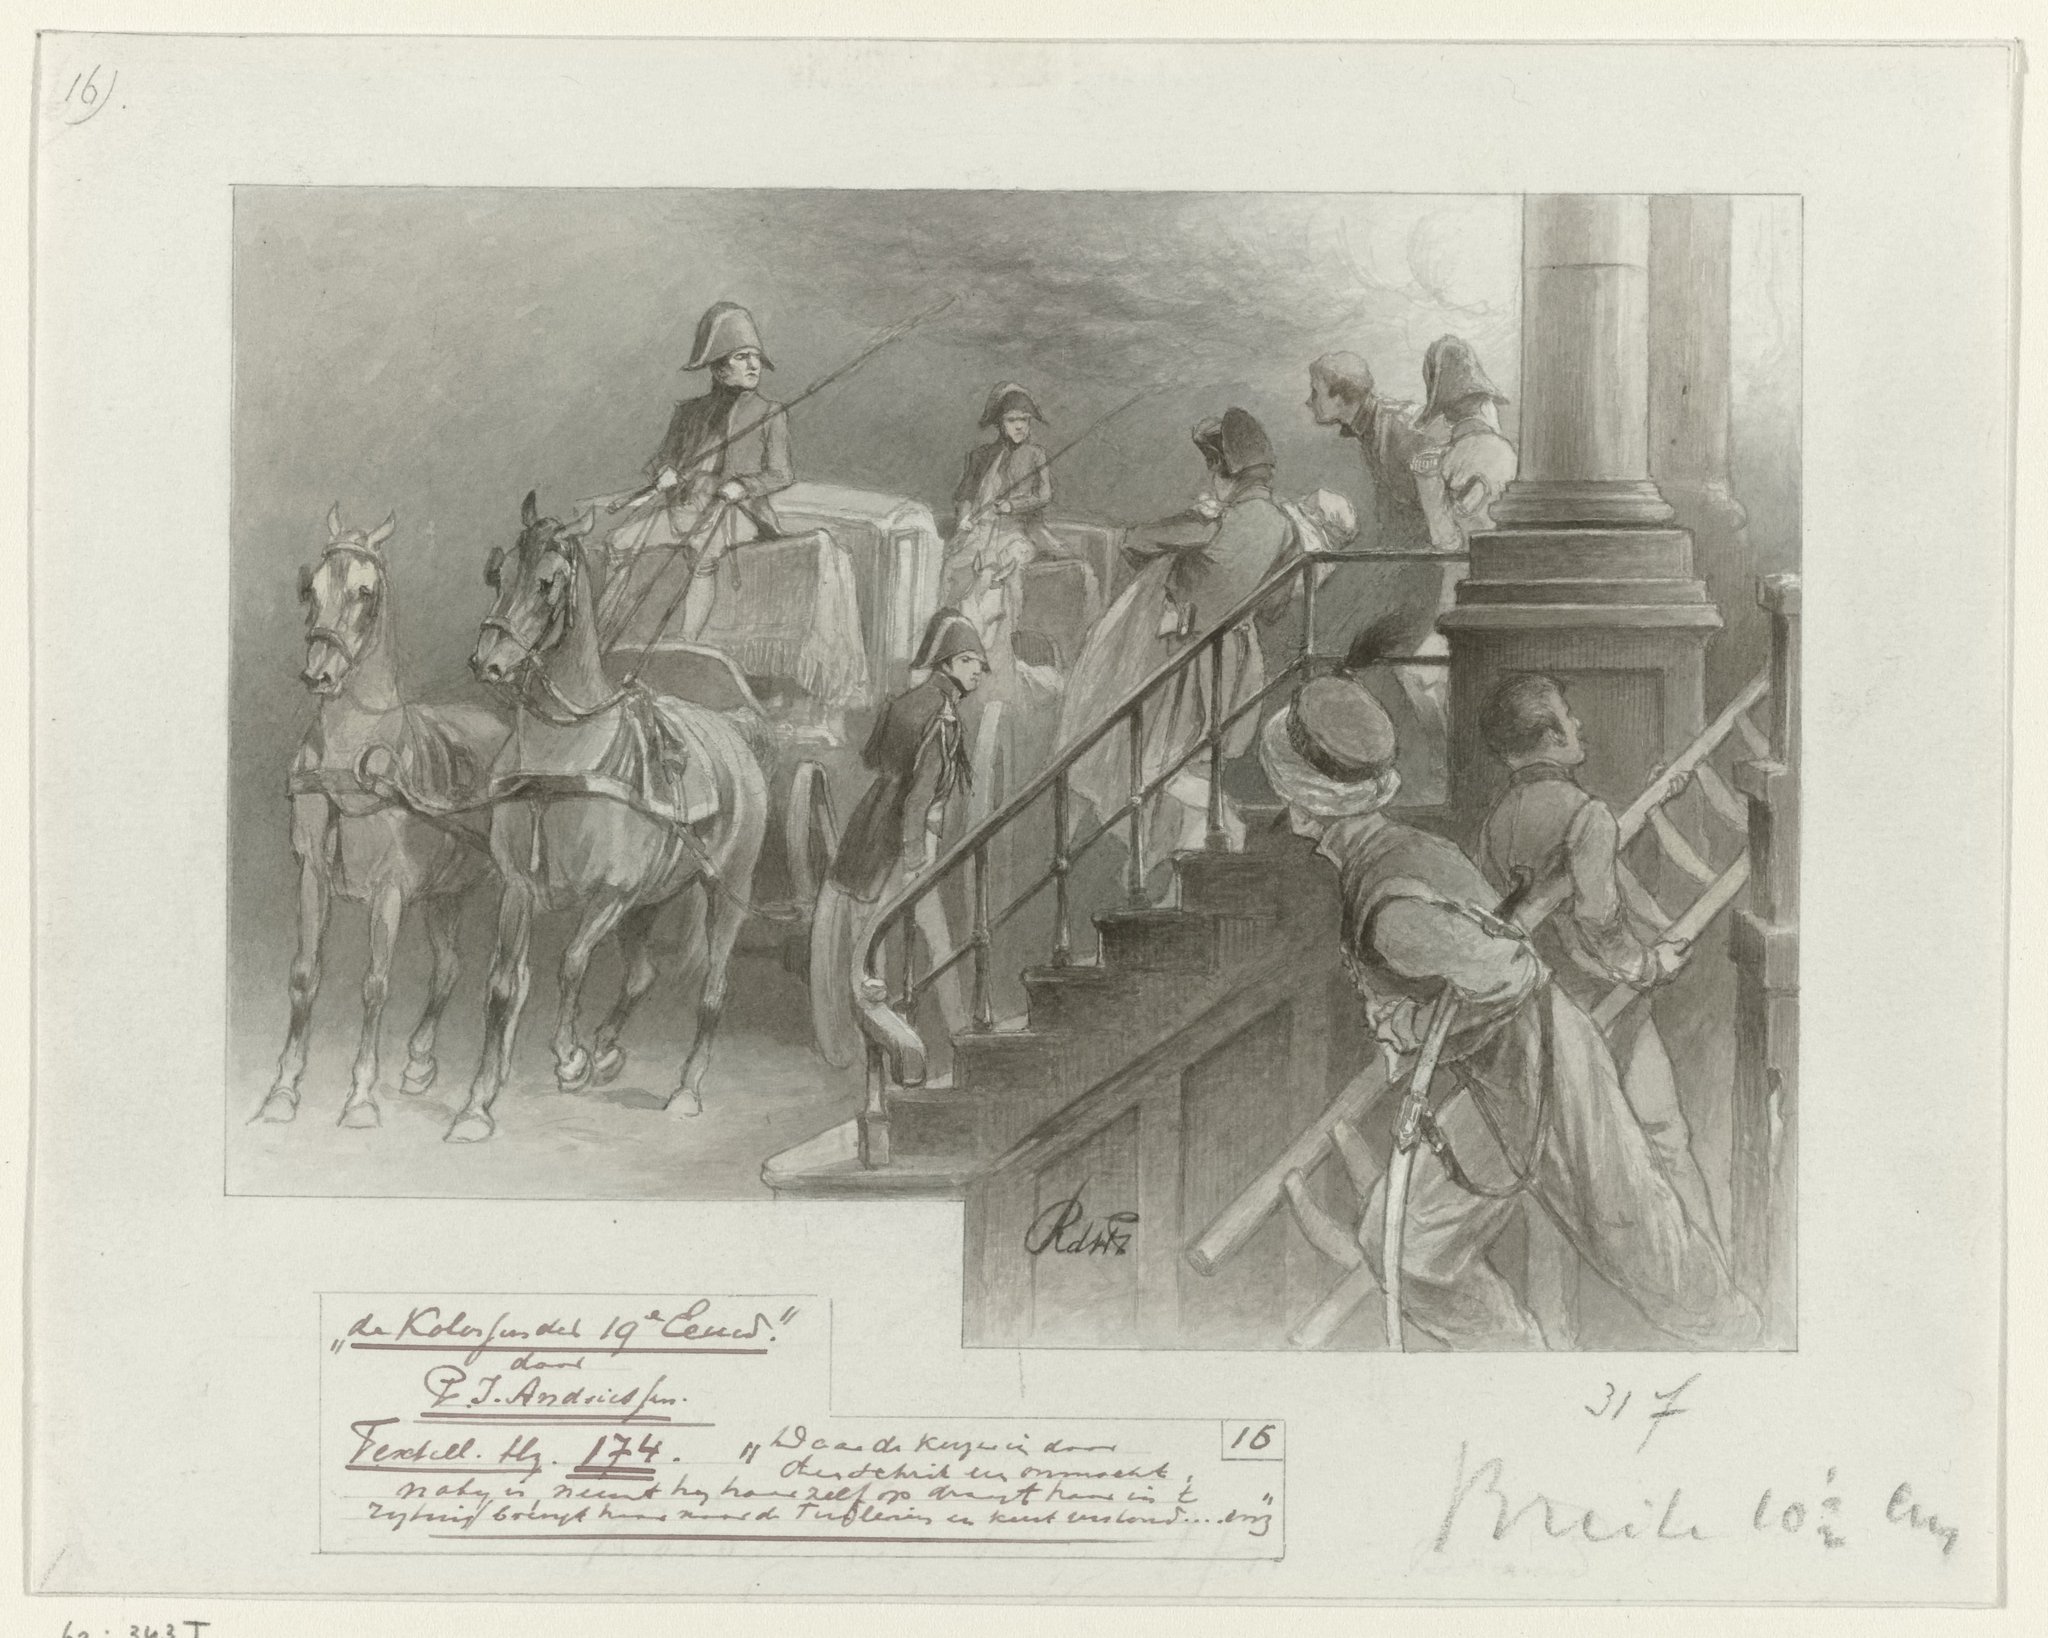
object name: design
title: Ontwerp voor illustratie voor De Kolossus der Negentiende Eeuw door P.J. Andriessen (Textill., blz. 174); scène uit het leven van Napoleon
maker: george lodewijk de wetstein pfister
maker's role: draughtsman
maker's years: 1867-1942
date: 1877-1942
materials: ink, paper, pencil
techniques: brush, pen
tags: napoleon i (emperor of the french), (andriessen, de kolossus der negentiende eeuw) specific works of literature (with author, title), historical persons, illustration ~ printed matter, book, historical events and situations